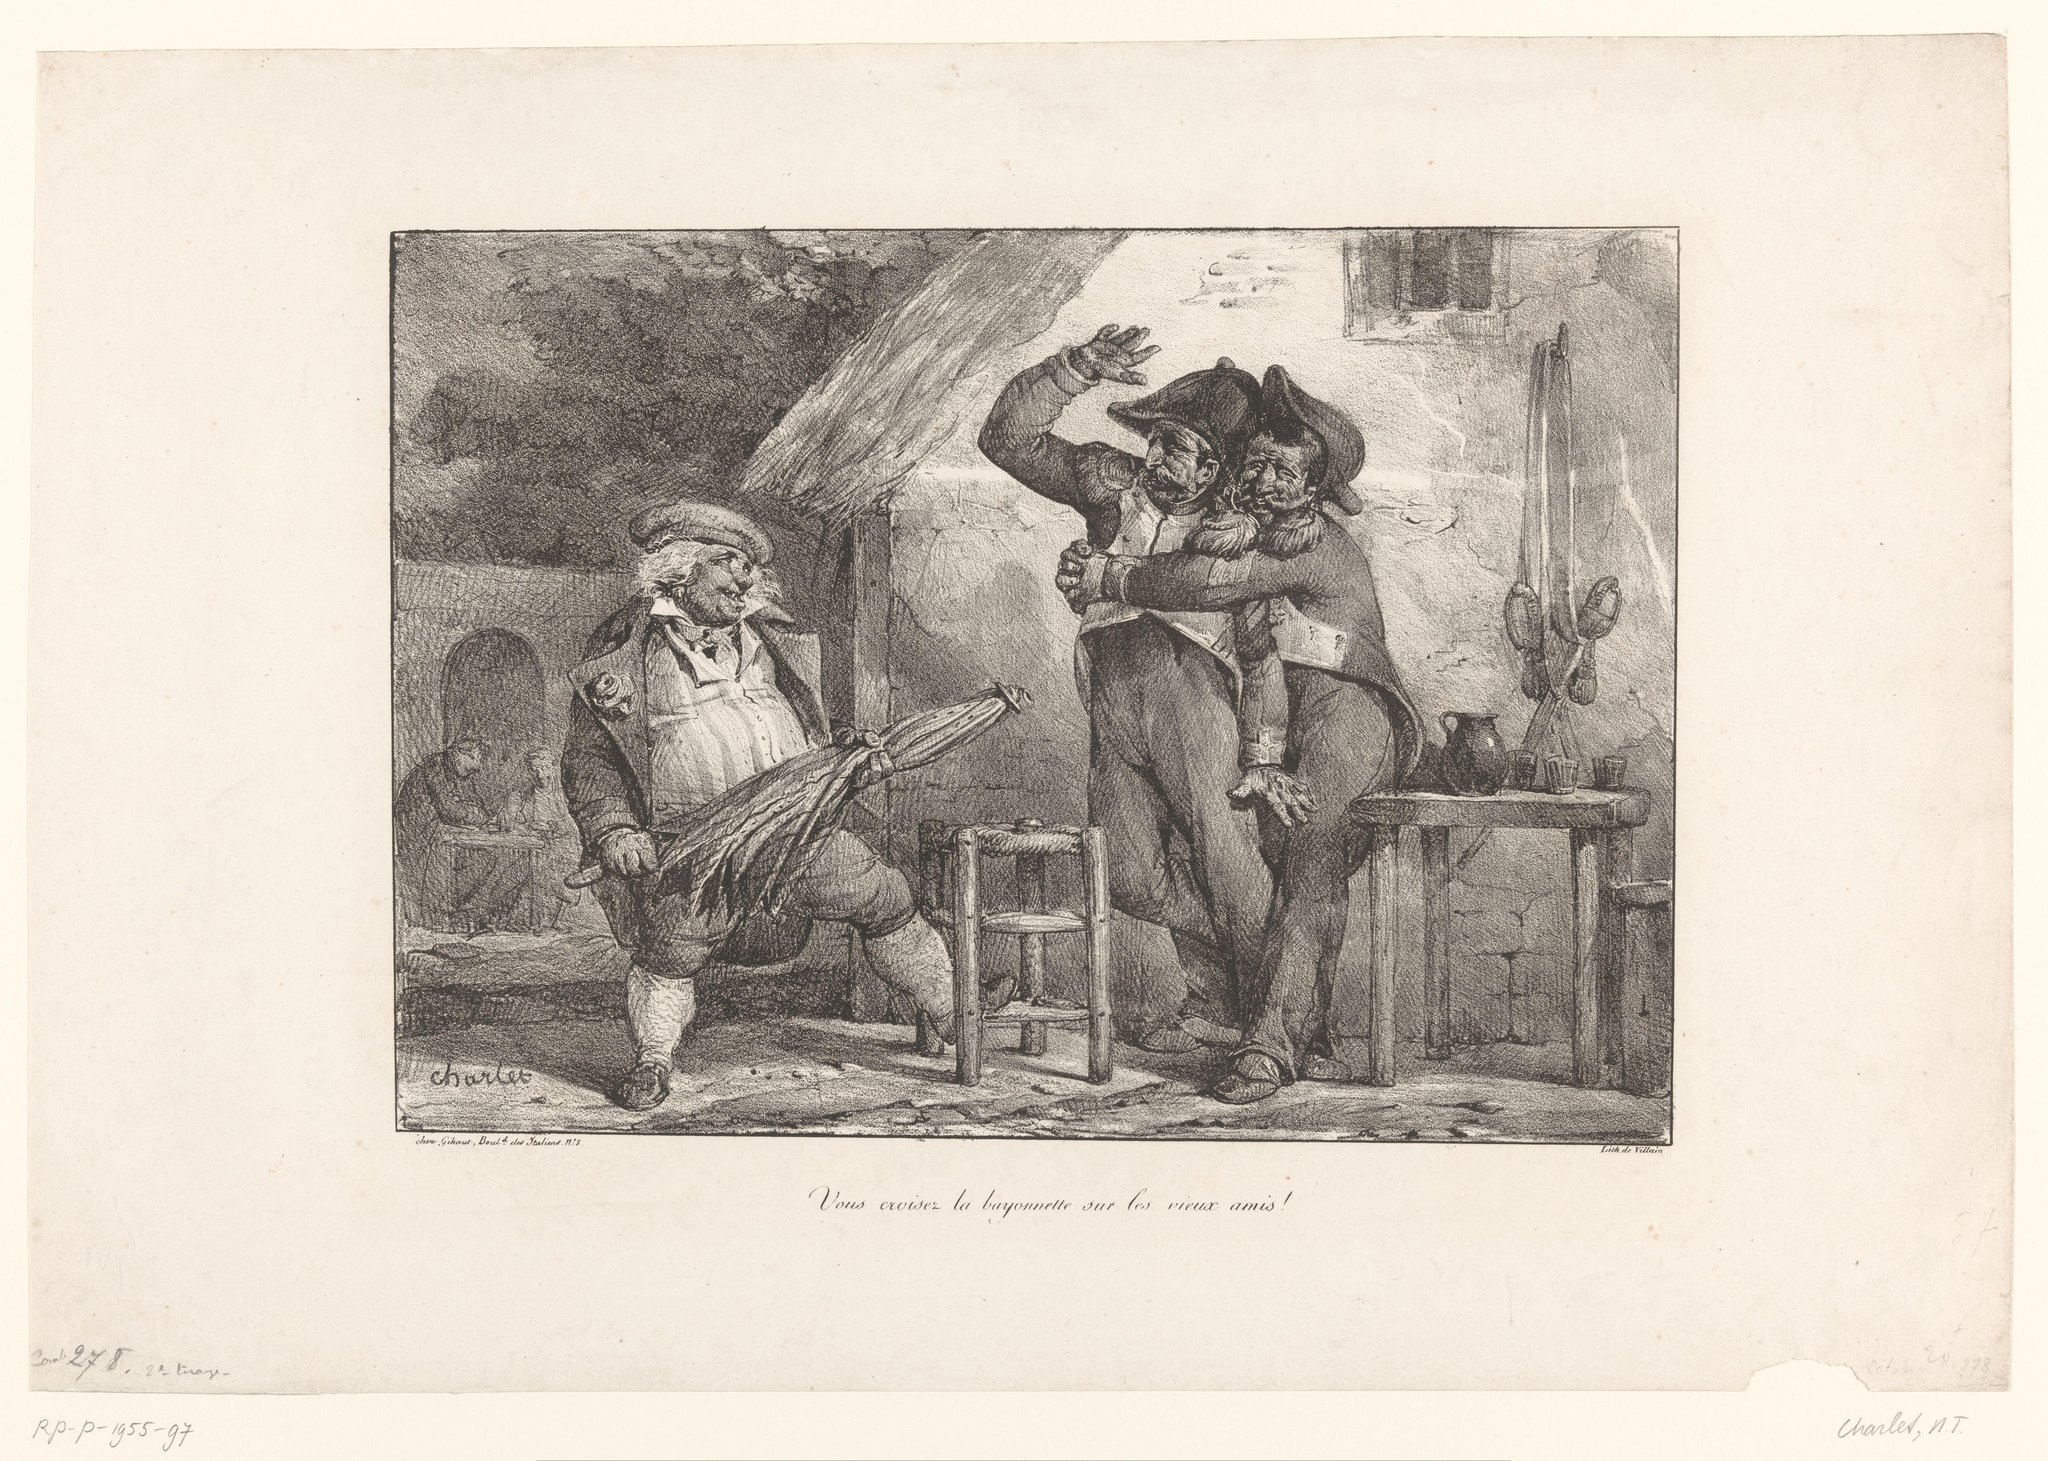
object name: print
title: Vous croisez la bayonnette sur les vieux amis!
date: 1822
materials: paper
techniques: lithograph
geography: paris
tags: canteen ~ the soldier off duty, drunkard, mocking, insulting; teasing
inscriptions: collector's mark: Lugt 2228a